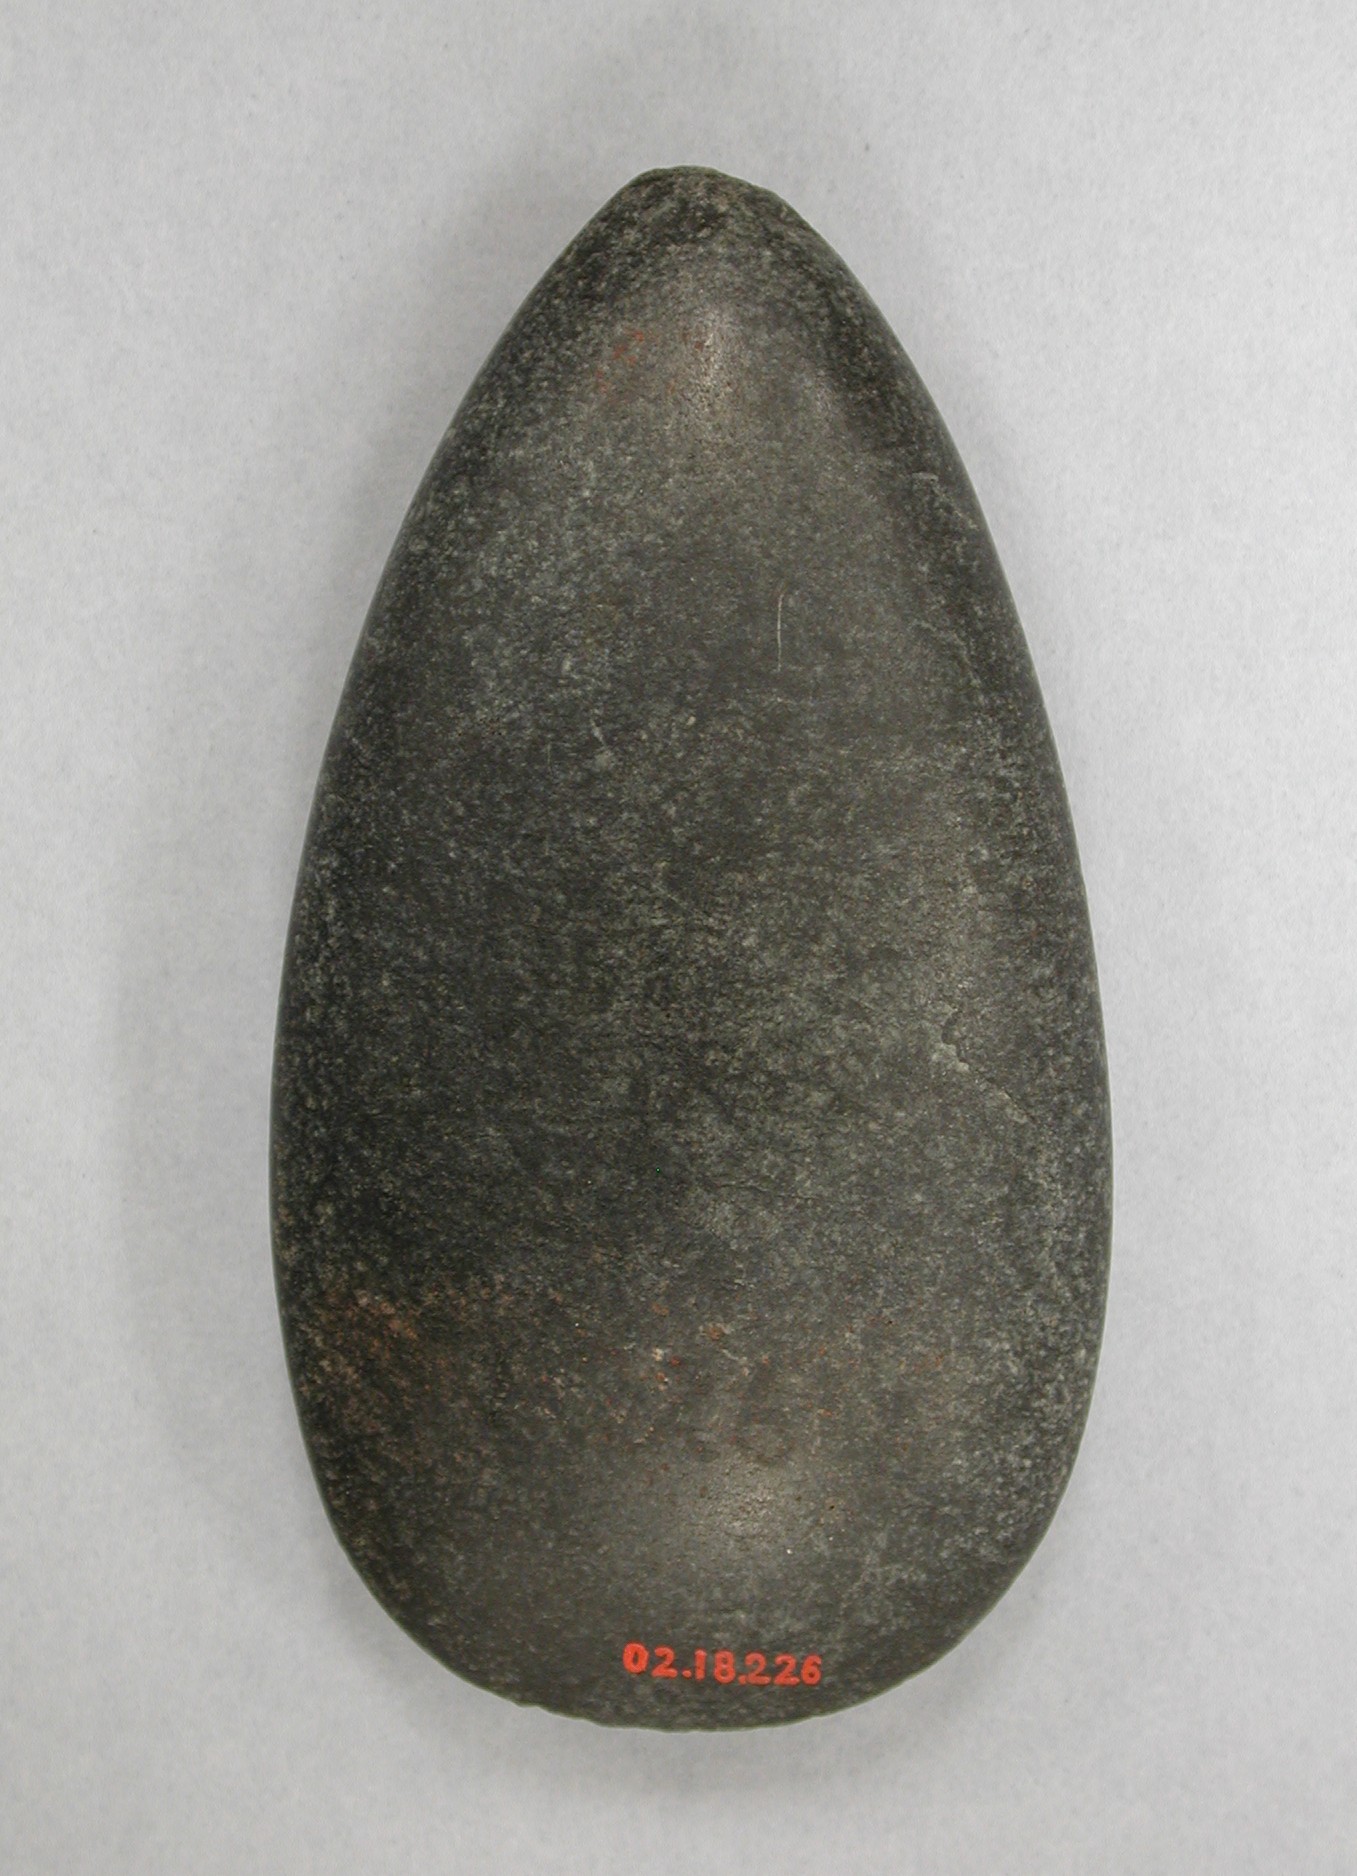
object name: hatchet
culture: jamaica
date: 1902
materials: jade